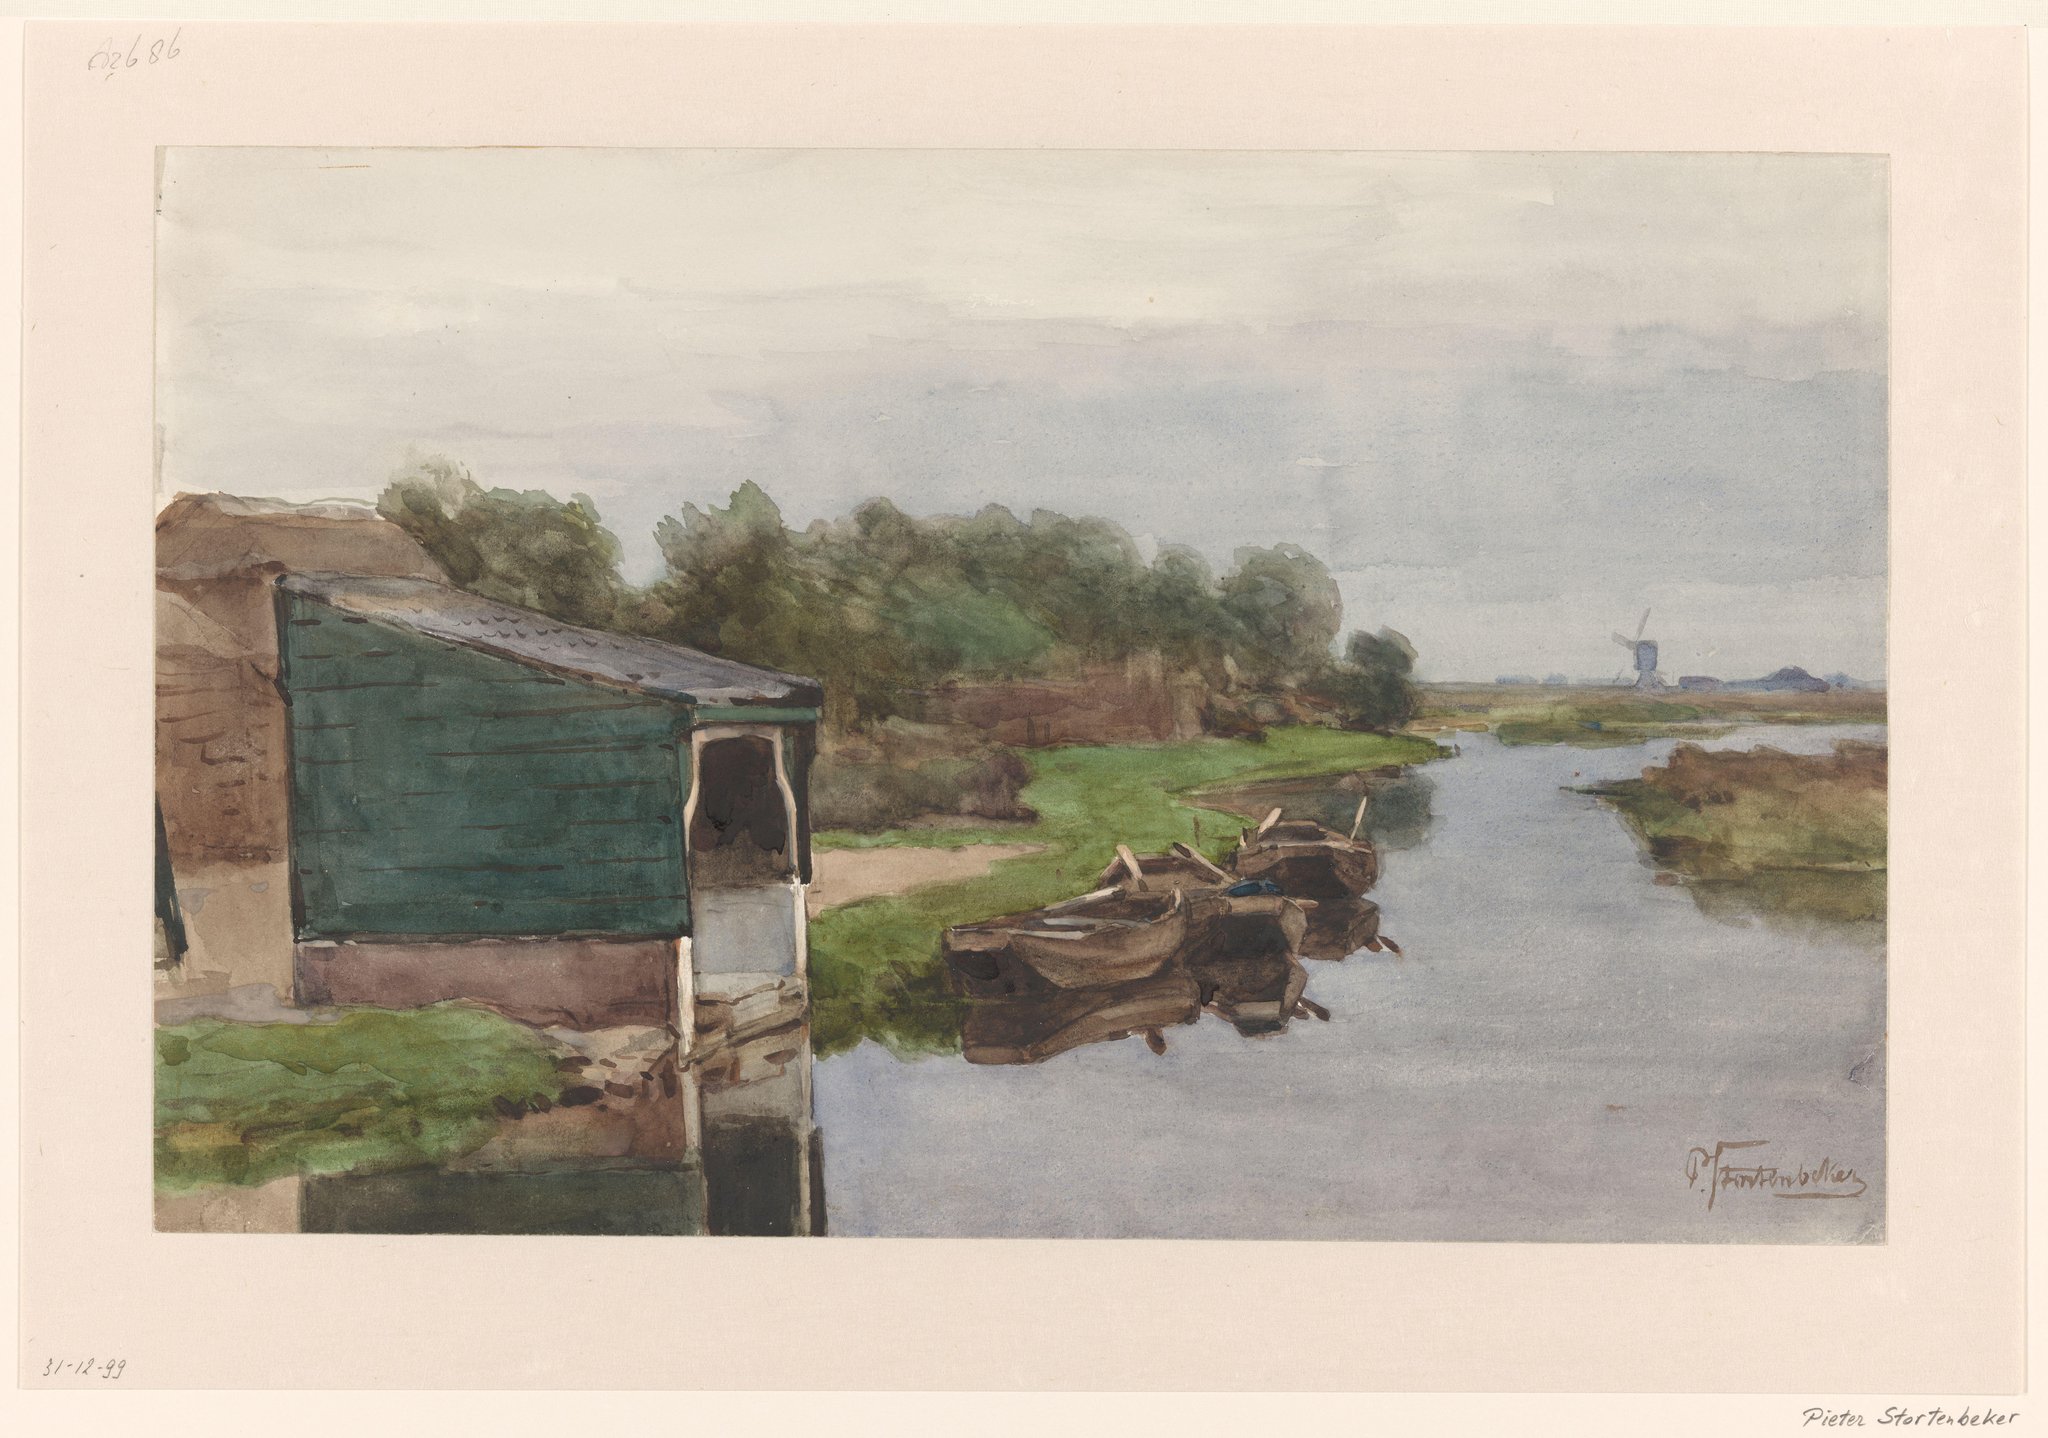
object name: drawing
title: Wetering met enkele bootjes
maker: pieter stortenbeker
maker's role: draughtsman, painter, print maker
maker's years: 1828-1898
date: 1838-1892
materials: paper, watercolor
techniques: brush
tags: farm or solitary house in landscape